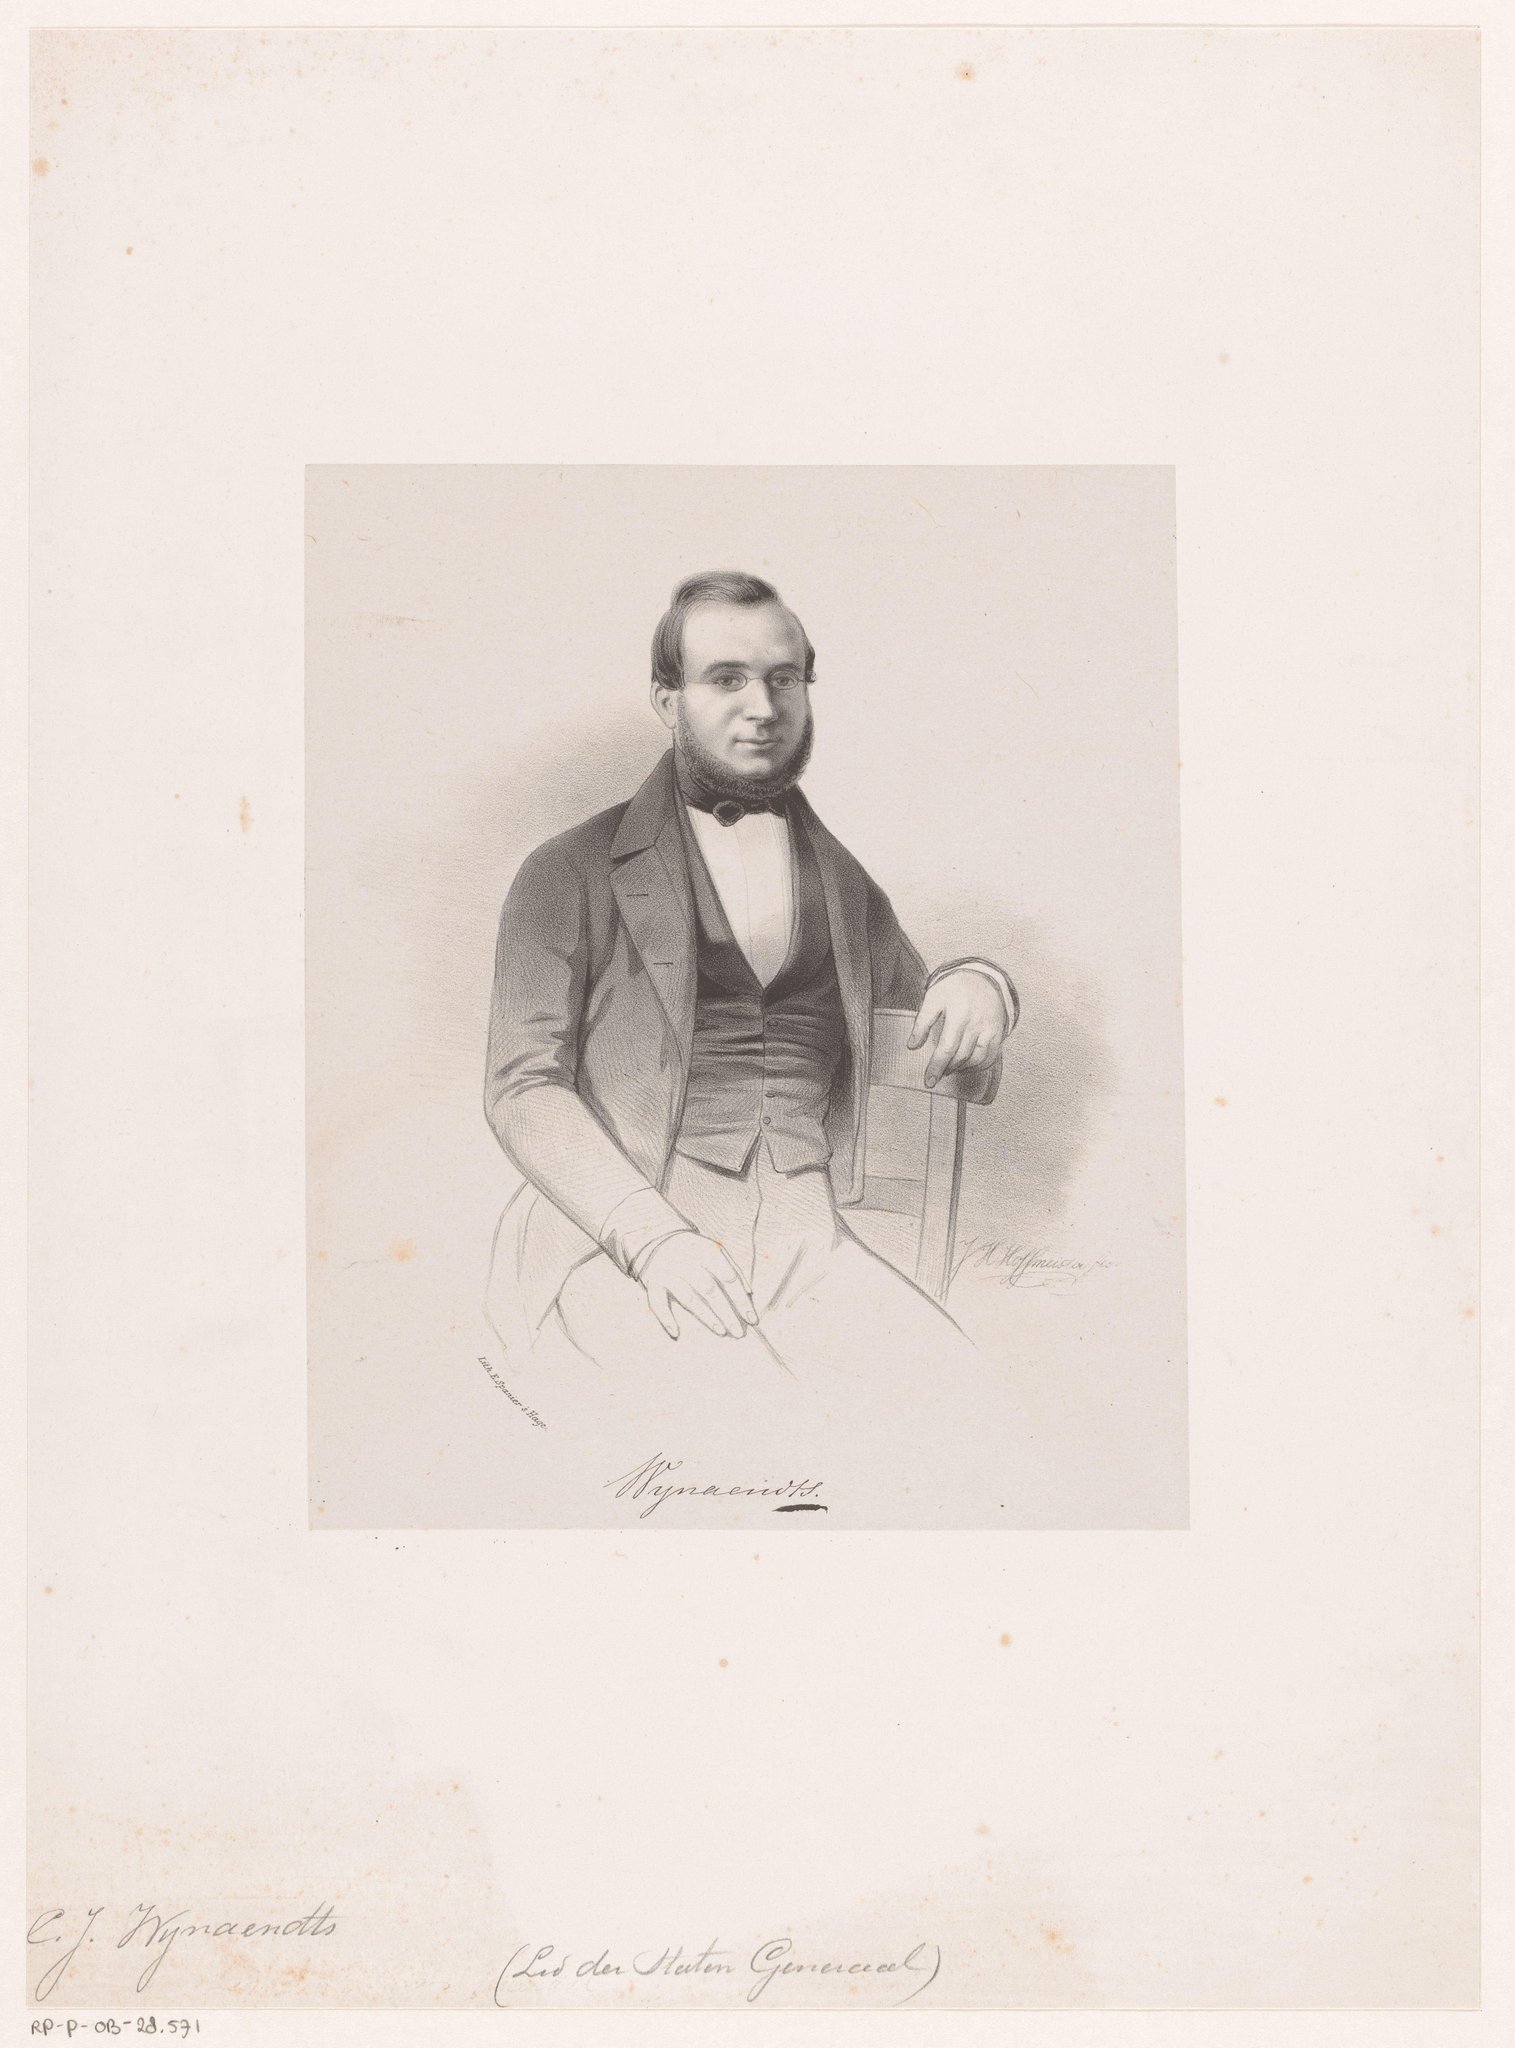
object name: print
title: Portret van C. J. Wijnaendts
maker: johan hendrik hoffmeister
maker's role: print maker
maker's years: 1823-1904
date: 1851-1883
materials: paper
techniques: lithograph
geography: netherlands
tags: historical persons (+ half-length portrait)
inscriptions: collector's mark: Lugt 2228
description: Volgens Van Someren was Wijnaendts (1801-1876) hervormd predikant te Warnsveld.